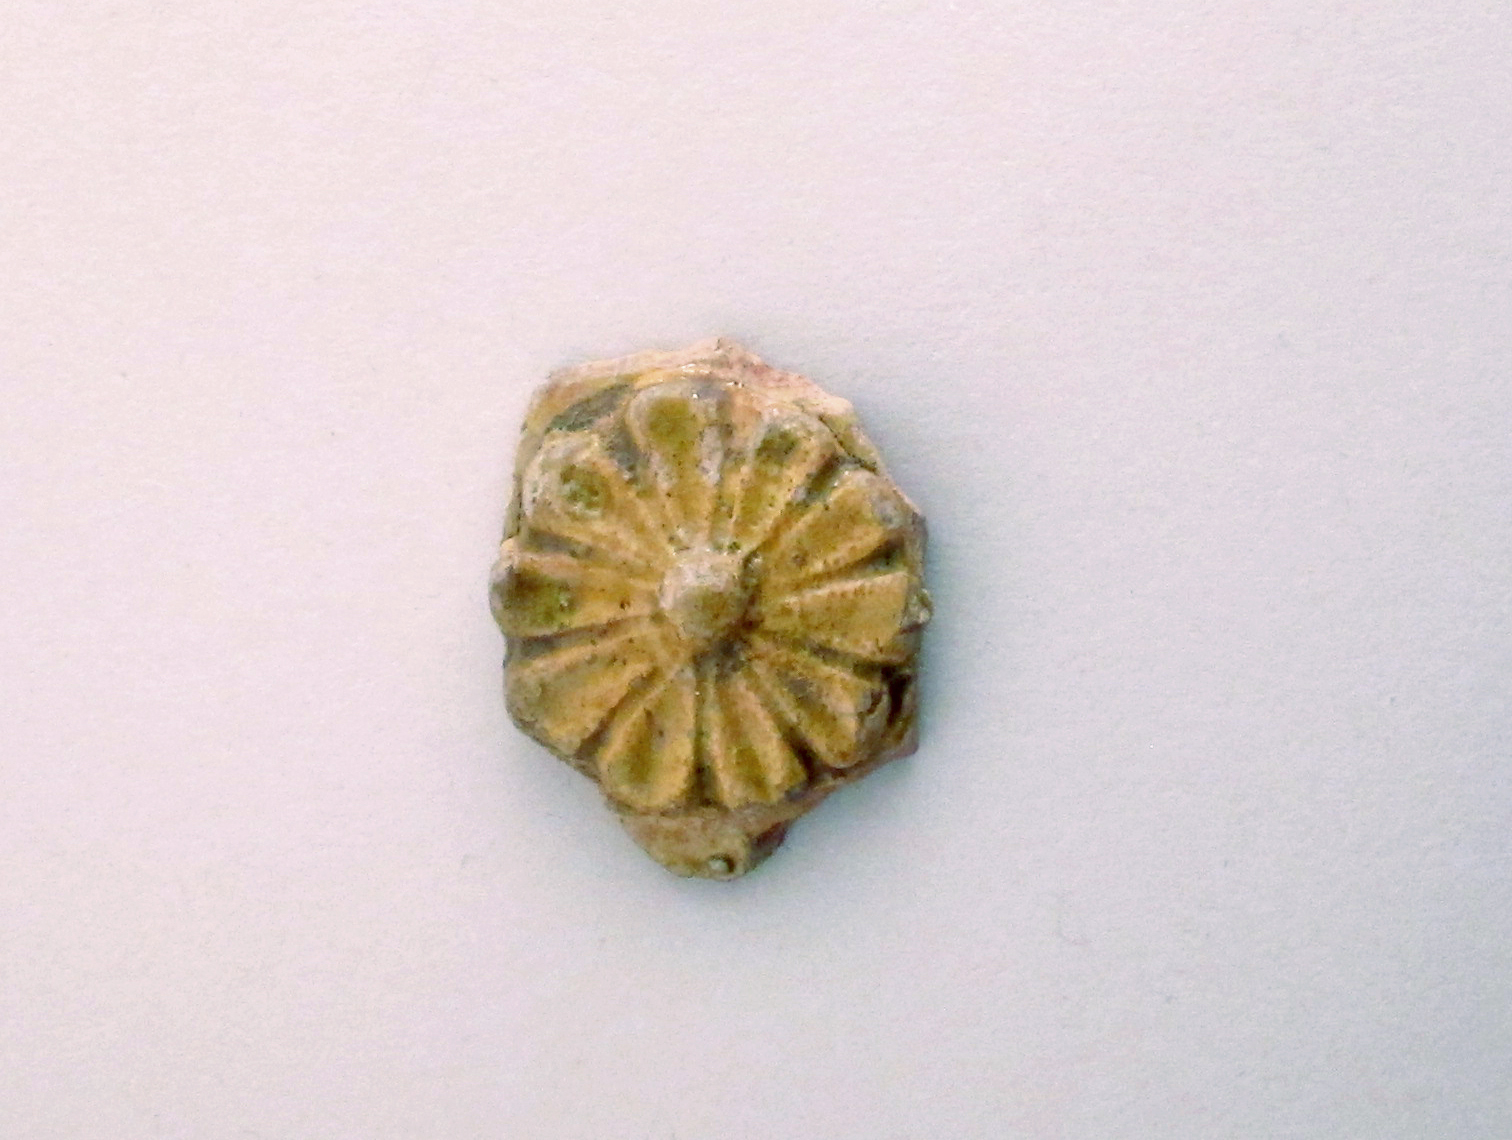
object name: vase fragment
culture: roman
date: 670 BCE-330 CE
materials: terracotta